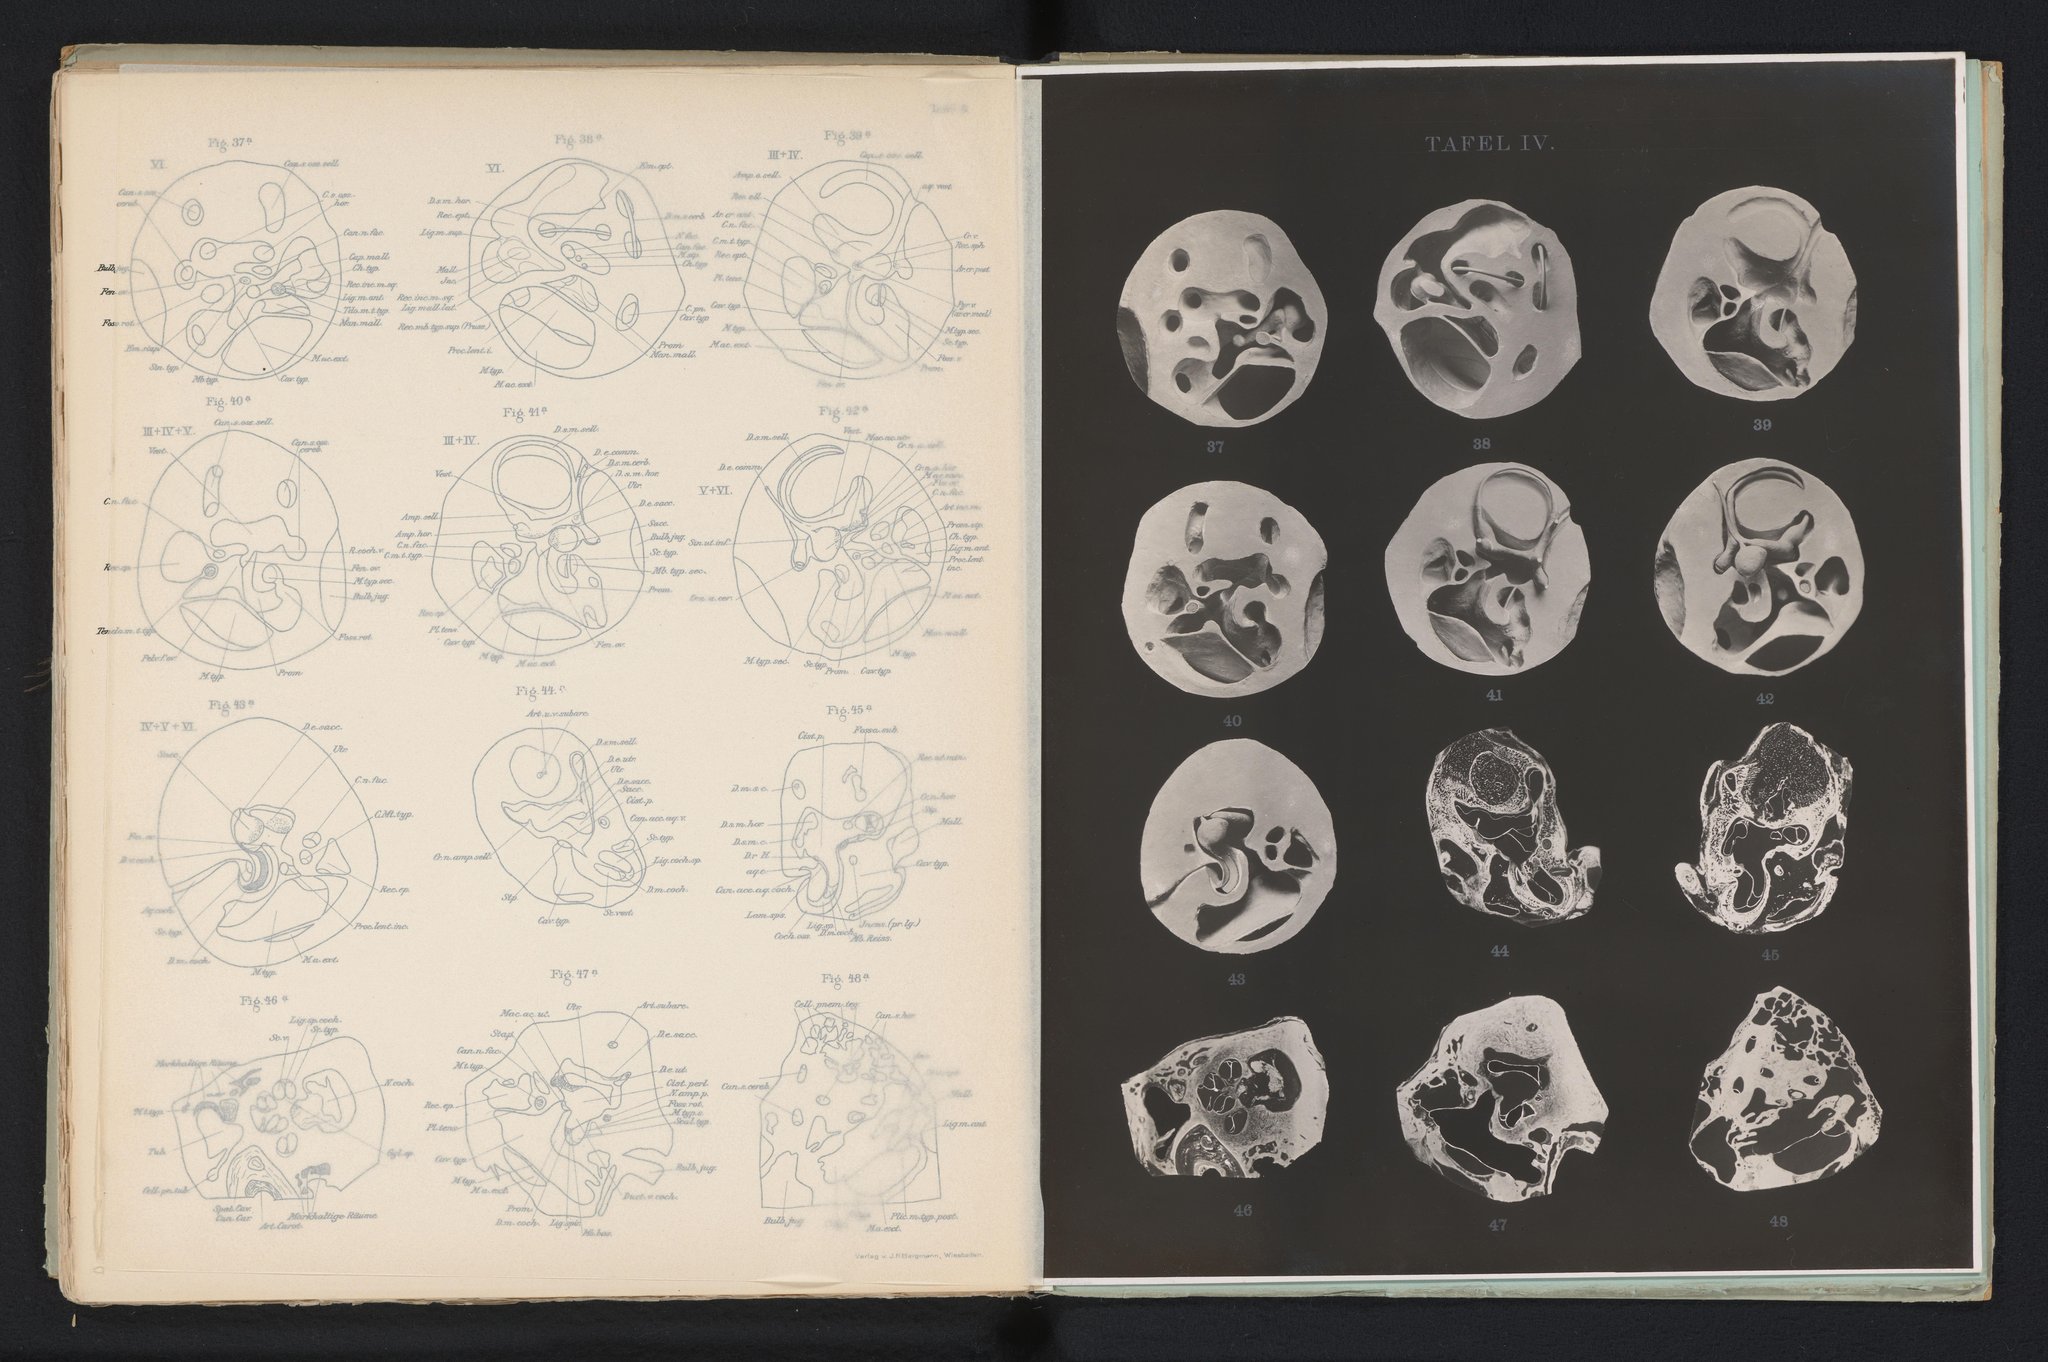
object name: photograph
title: Tafel IV.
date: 1899-1904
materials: paper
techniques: gelatin silver print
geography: wiesbaden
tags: physiology and anatomy ~ sense organs, ears